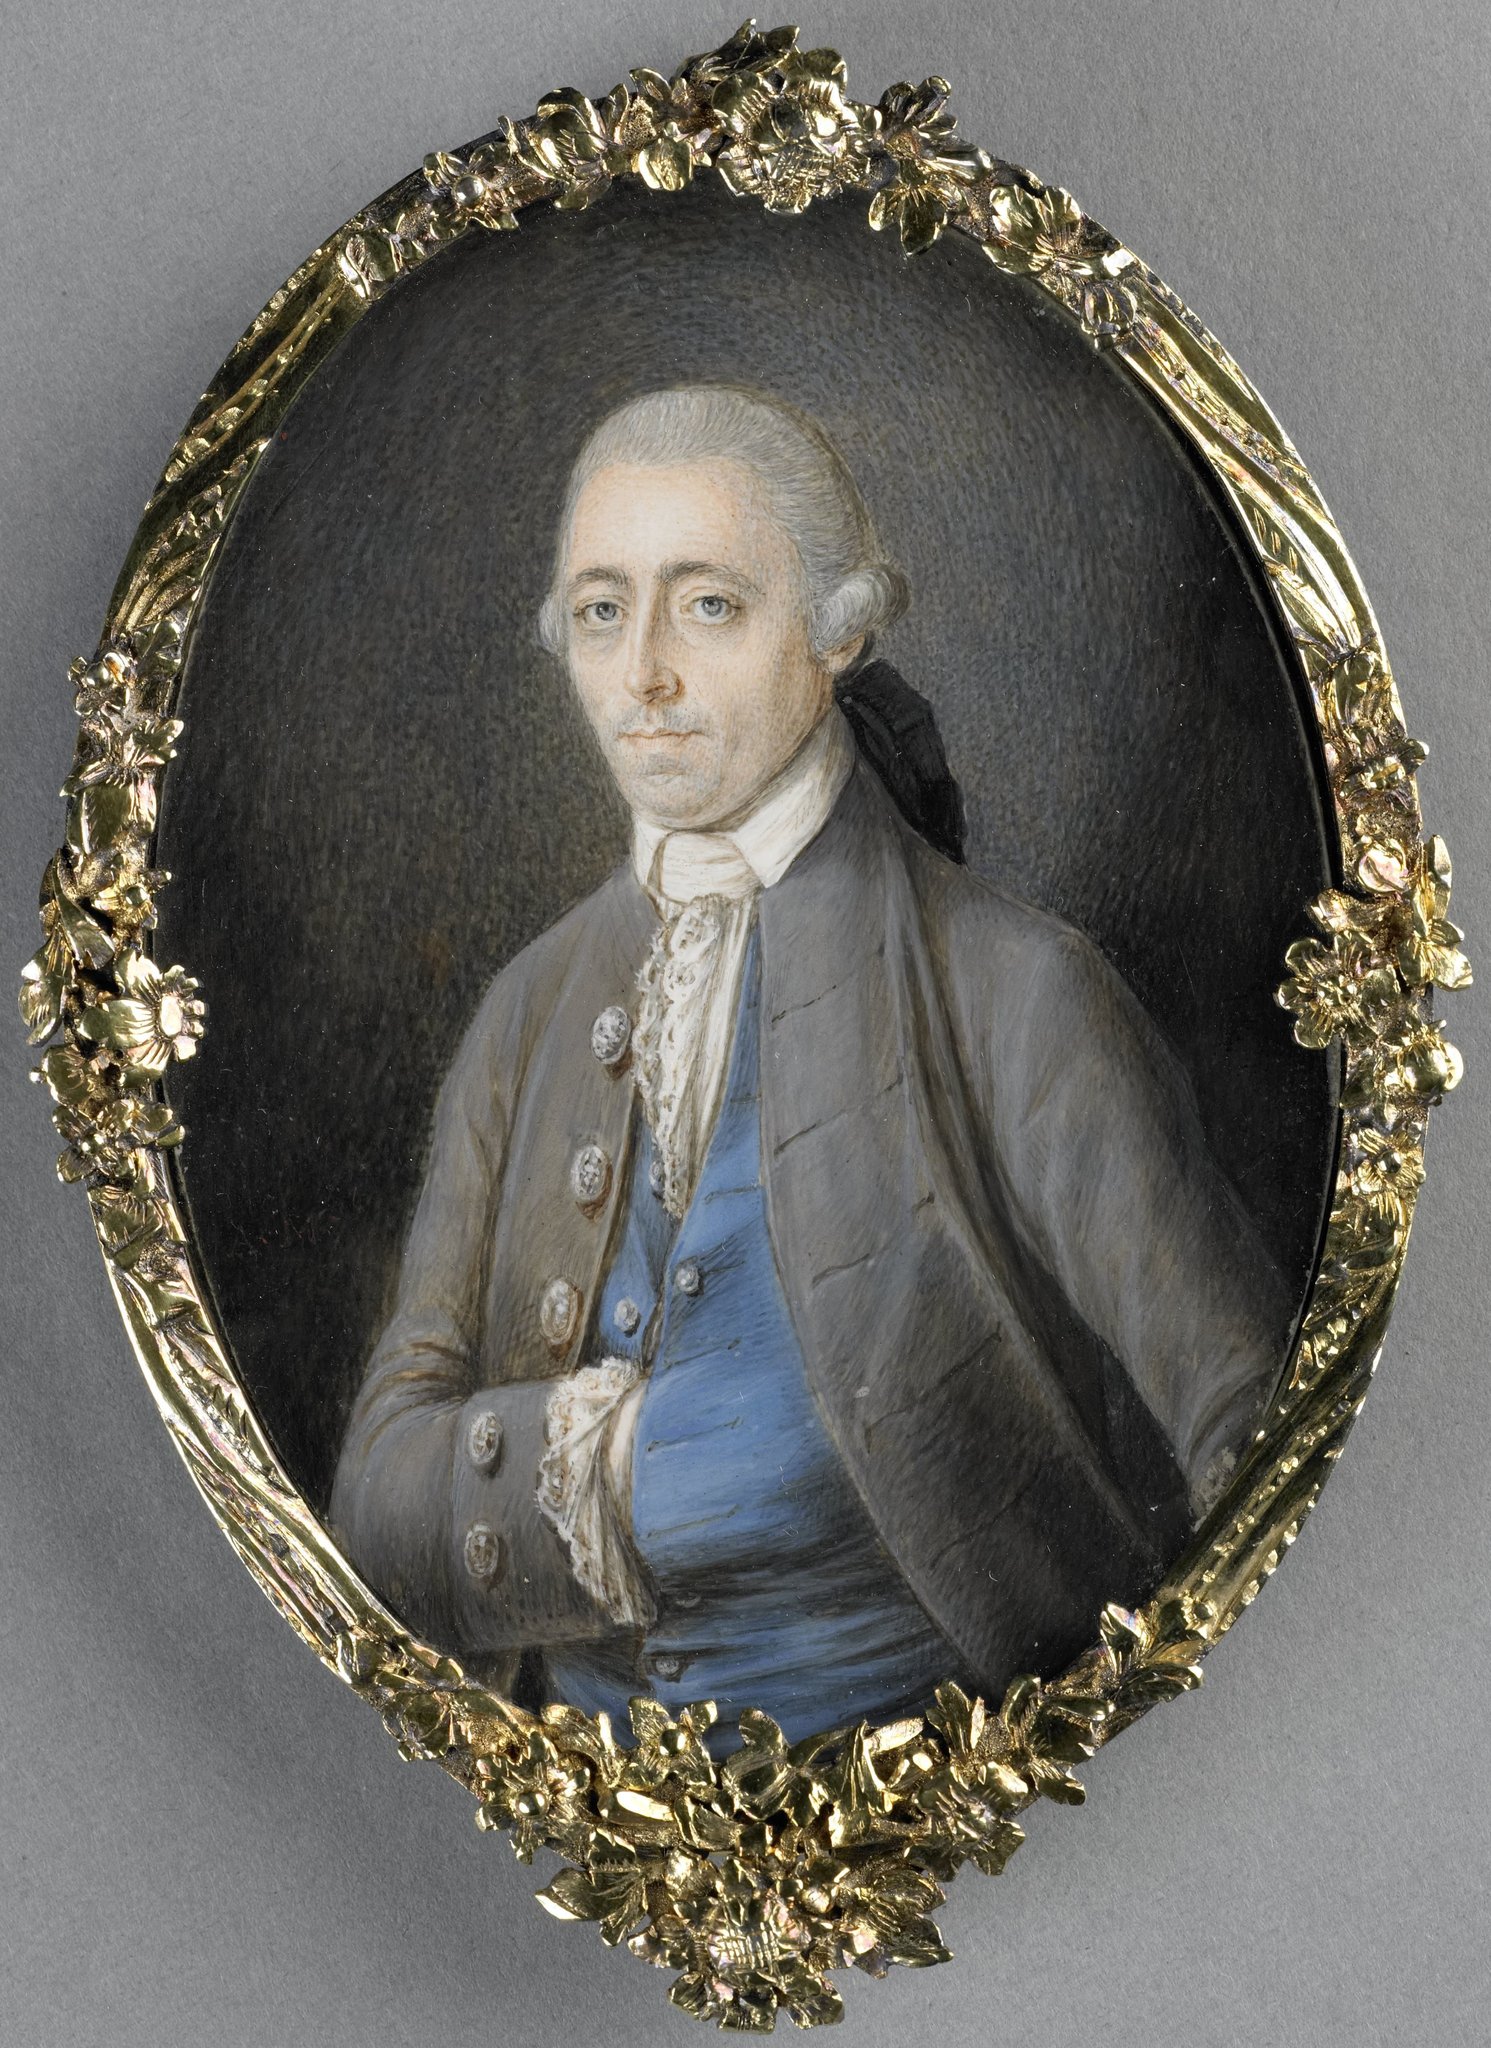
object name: painting, miniature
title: Portret van Johannes Wesenhagen (1743-1803)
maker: antoine maucourt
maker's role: miniatuurschilder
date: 1701-1781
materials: glass, ivory, metal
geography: paramaribo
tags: historical persons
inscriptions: inscription: ‘J. Wesenhagen Geboren te Harderwijk Den 11de Aug.t 1743 Geportraiteert door den Kunst Schilder Antoine Maucourt, in de Maand January Aº 1781 Te Paramaribo’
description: A. Maucourt. Portrait of A. Wesenhagen (1743 - 1803). Ivory, in a gold frame, 1781